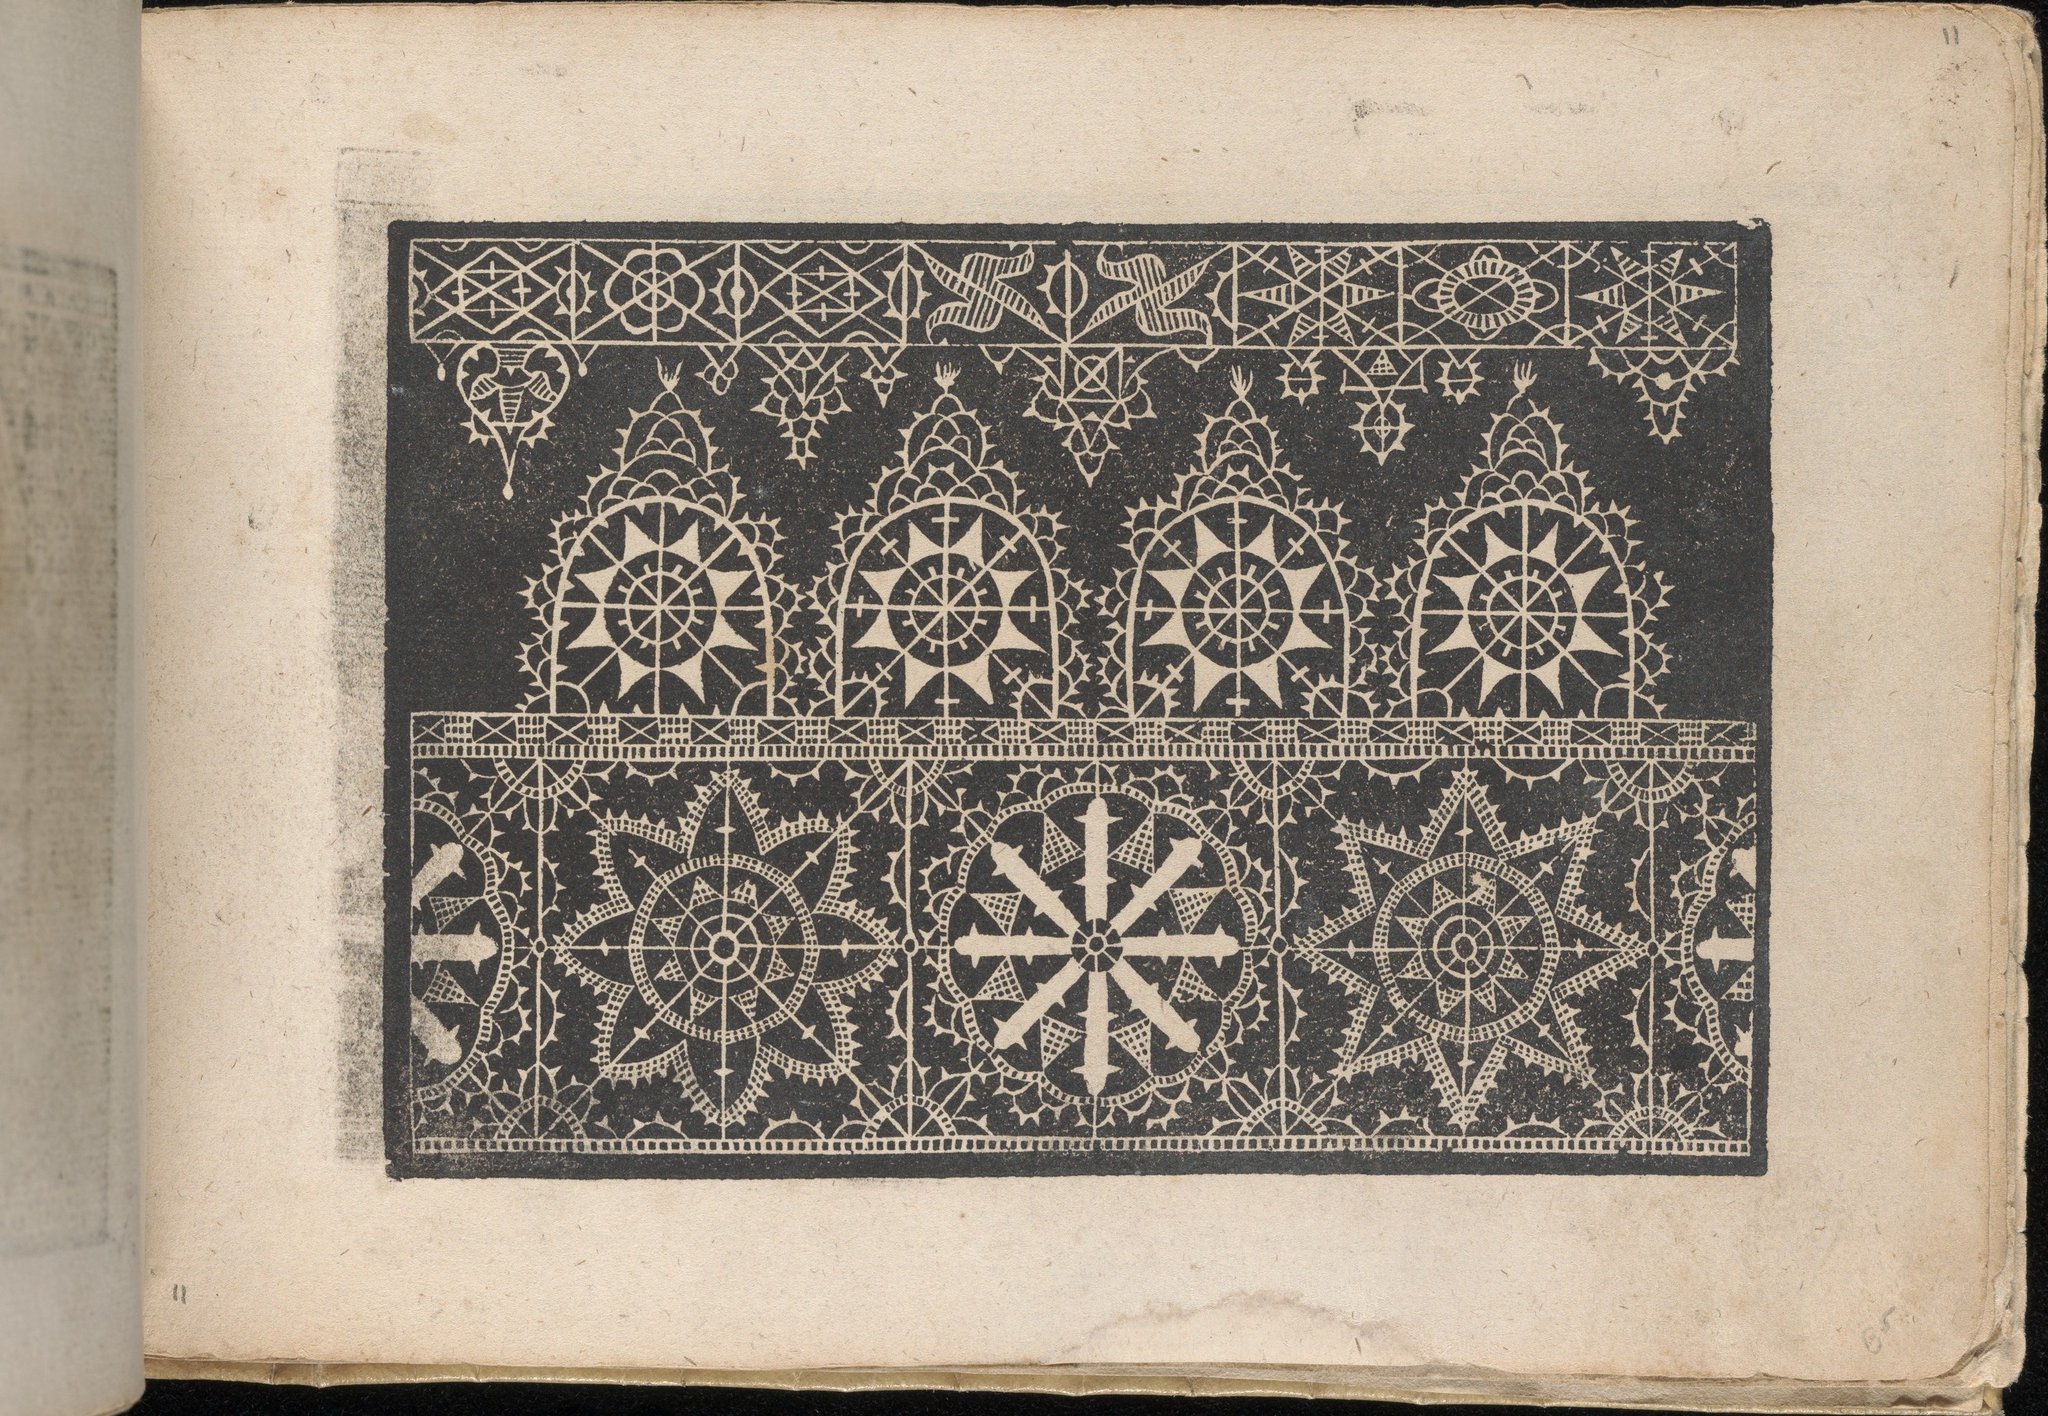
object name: book print ornament archiecture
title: Fiori di Ricami Nuovamente Posti in Luce, page 11 (recto)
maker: matteo florimi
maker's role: designer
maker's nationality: italian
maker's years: 1581-1613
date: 1591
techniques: woodcut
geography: italy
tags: ornament